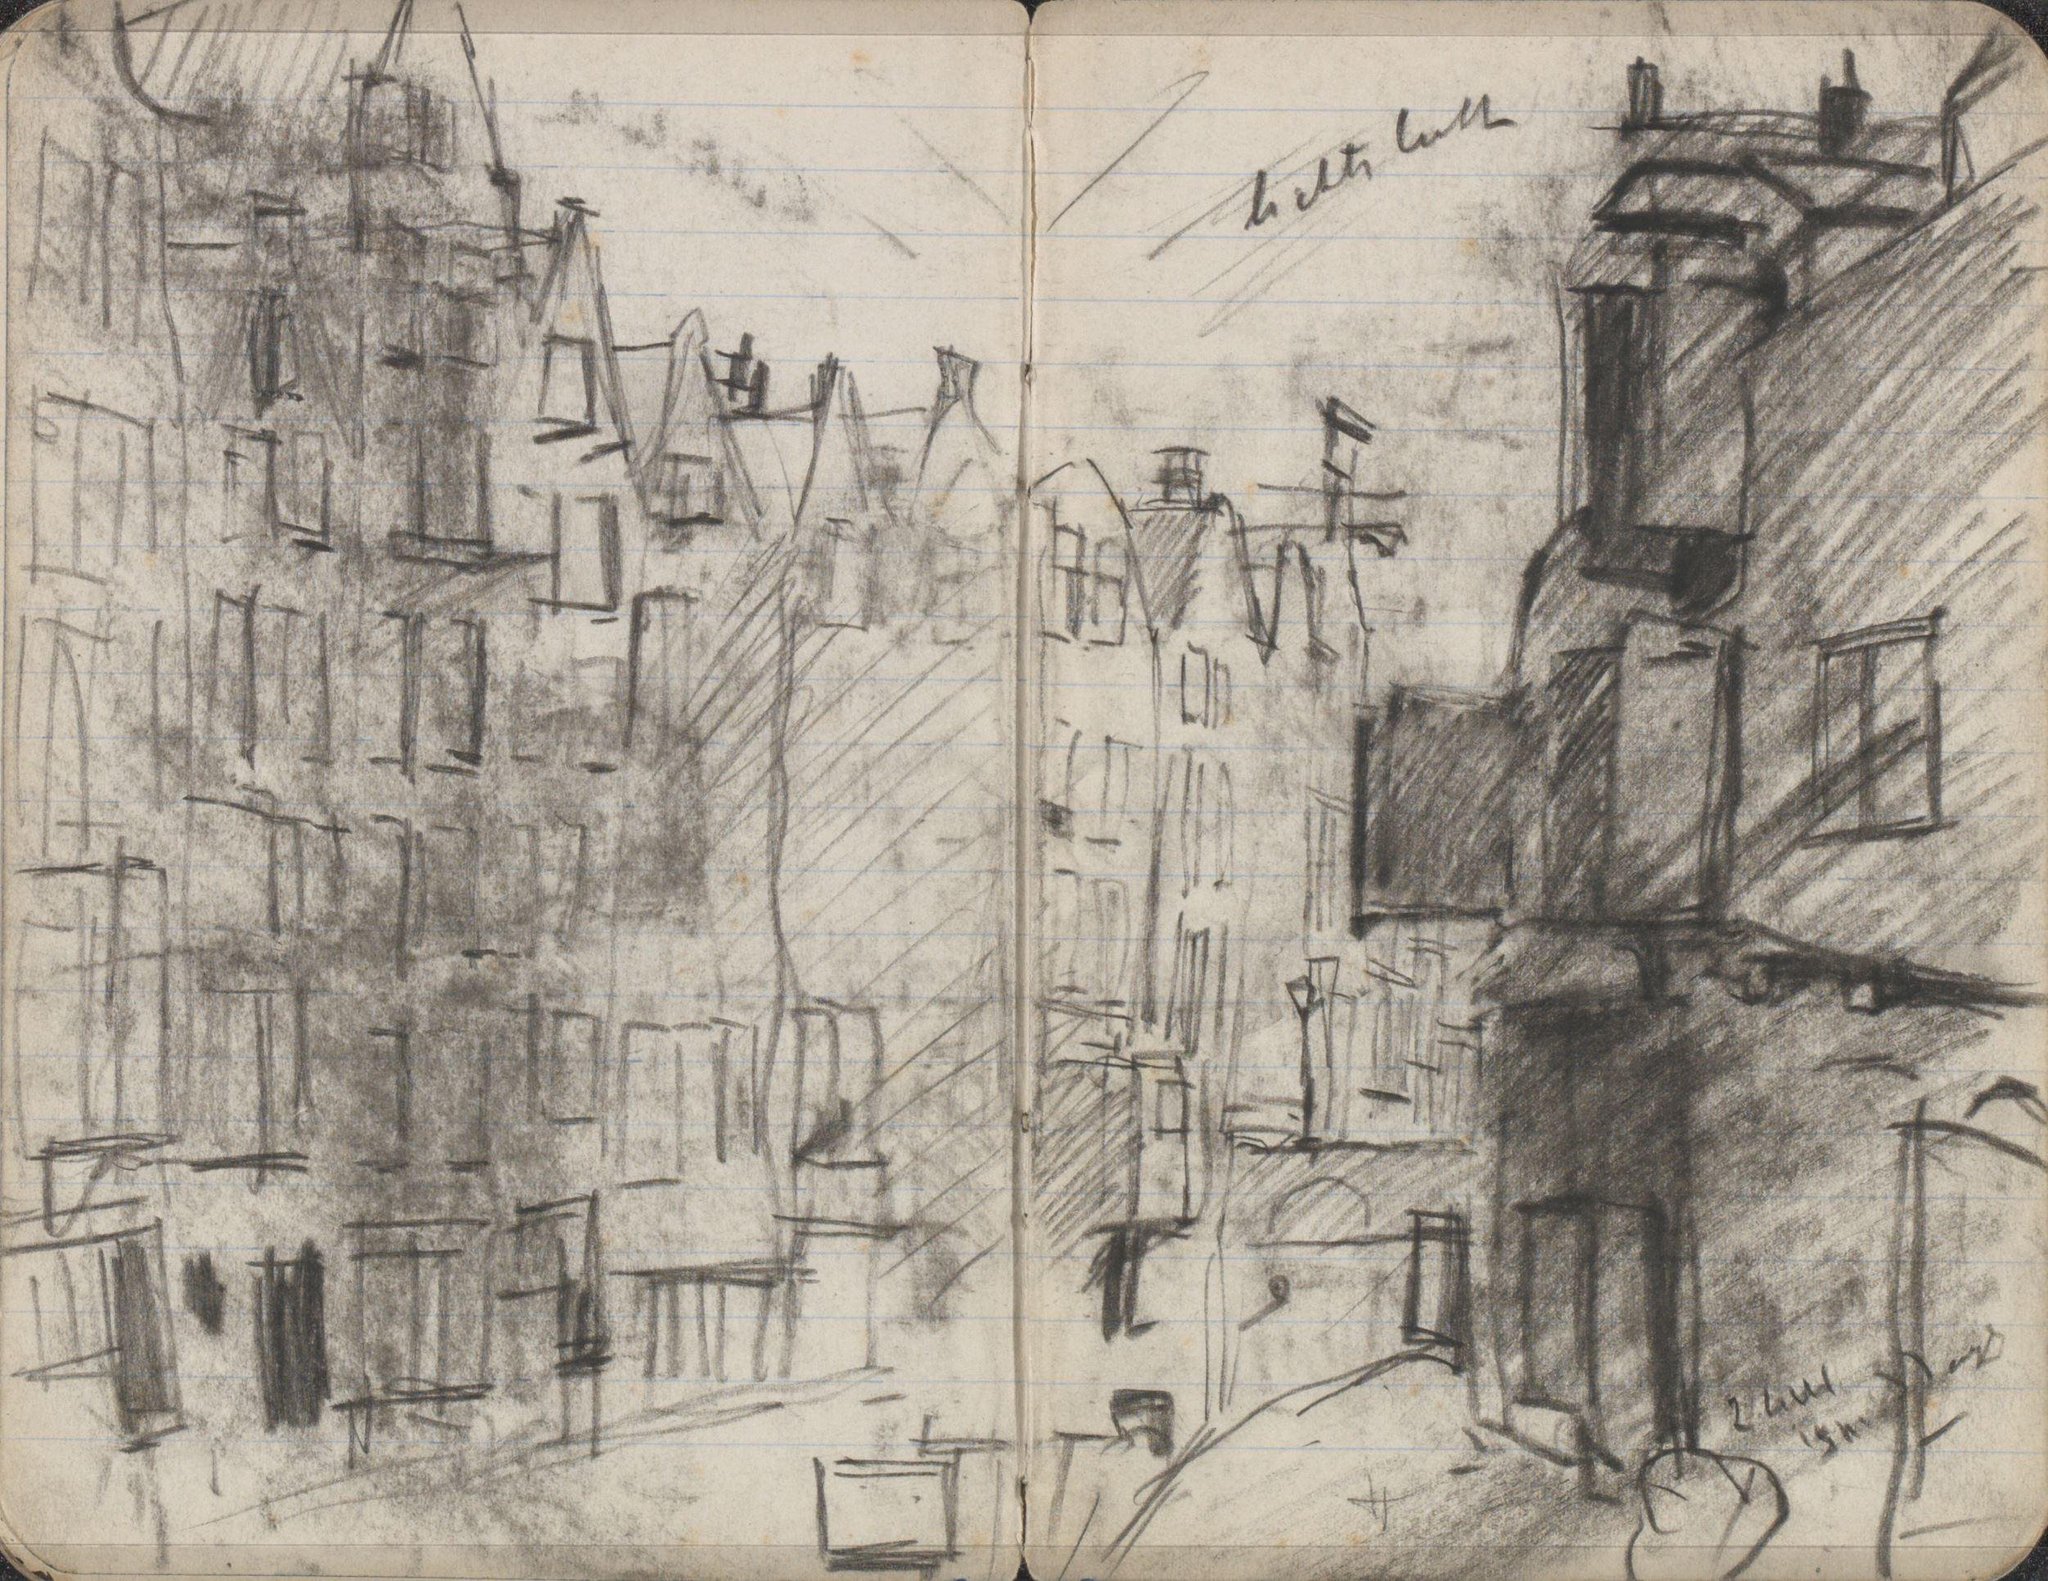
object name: sketchbook leaf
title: Oudezijds Achterburgwal te Amsterdam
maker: george hendrik breitner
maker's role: draughtsman, painter, print maker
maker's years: 1857-1923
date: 1897-1898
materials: chalk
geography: amsterdam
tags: canals, waters (in city), civic architecture; edifices; dwellings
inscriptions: annotation: ‘2 uur/ 's middags’, : ‘lichte lucht’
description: Oudezijds Achterburgwal met rechts het Kuipersgrachtje. Pagina 25 en pagina 26 uit een schetsboek met 42 bladen.